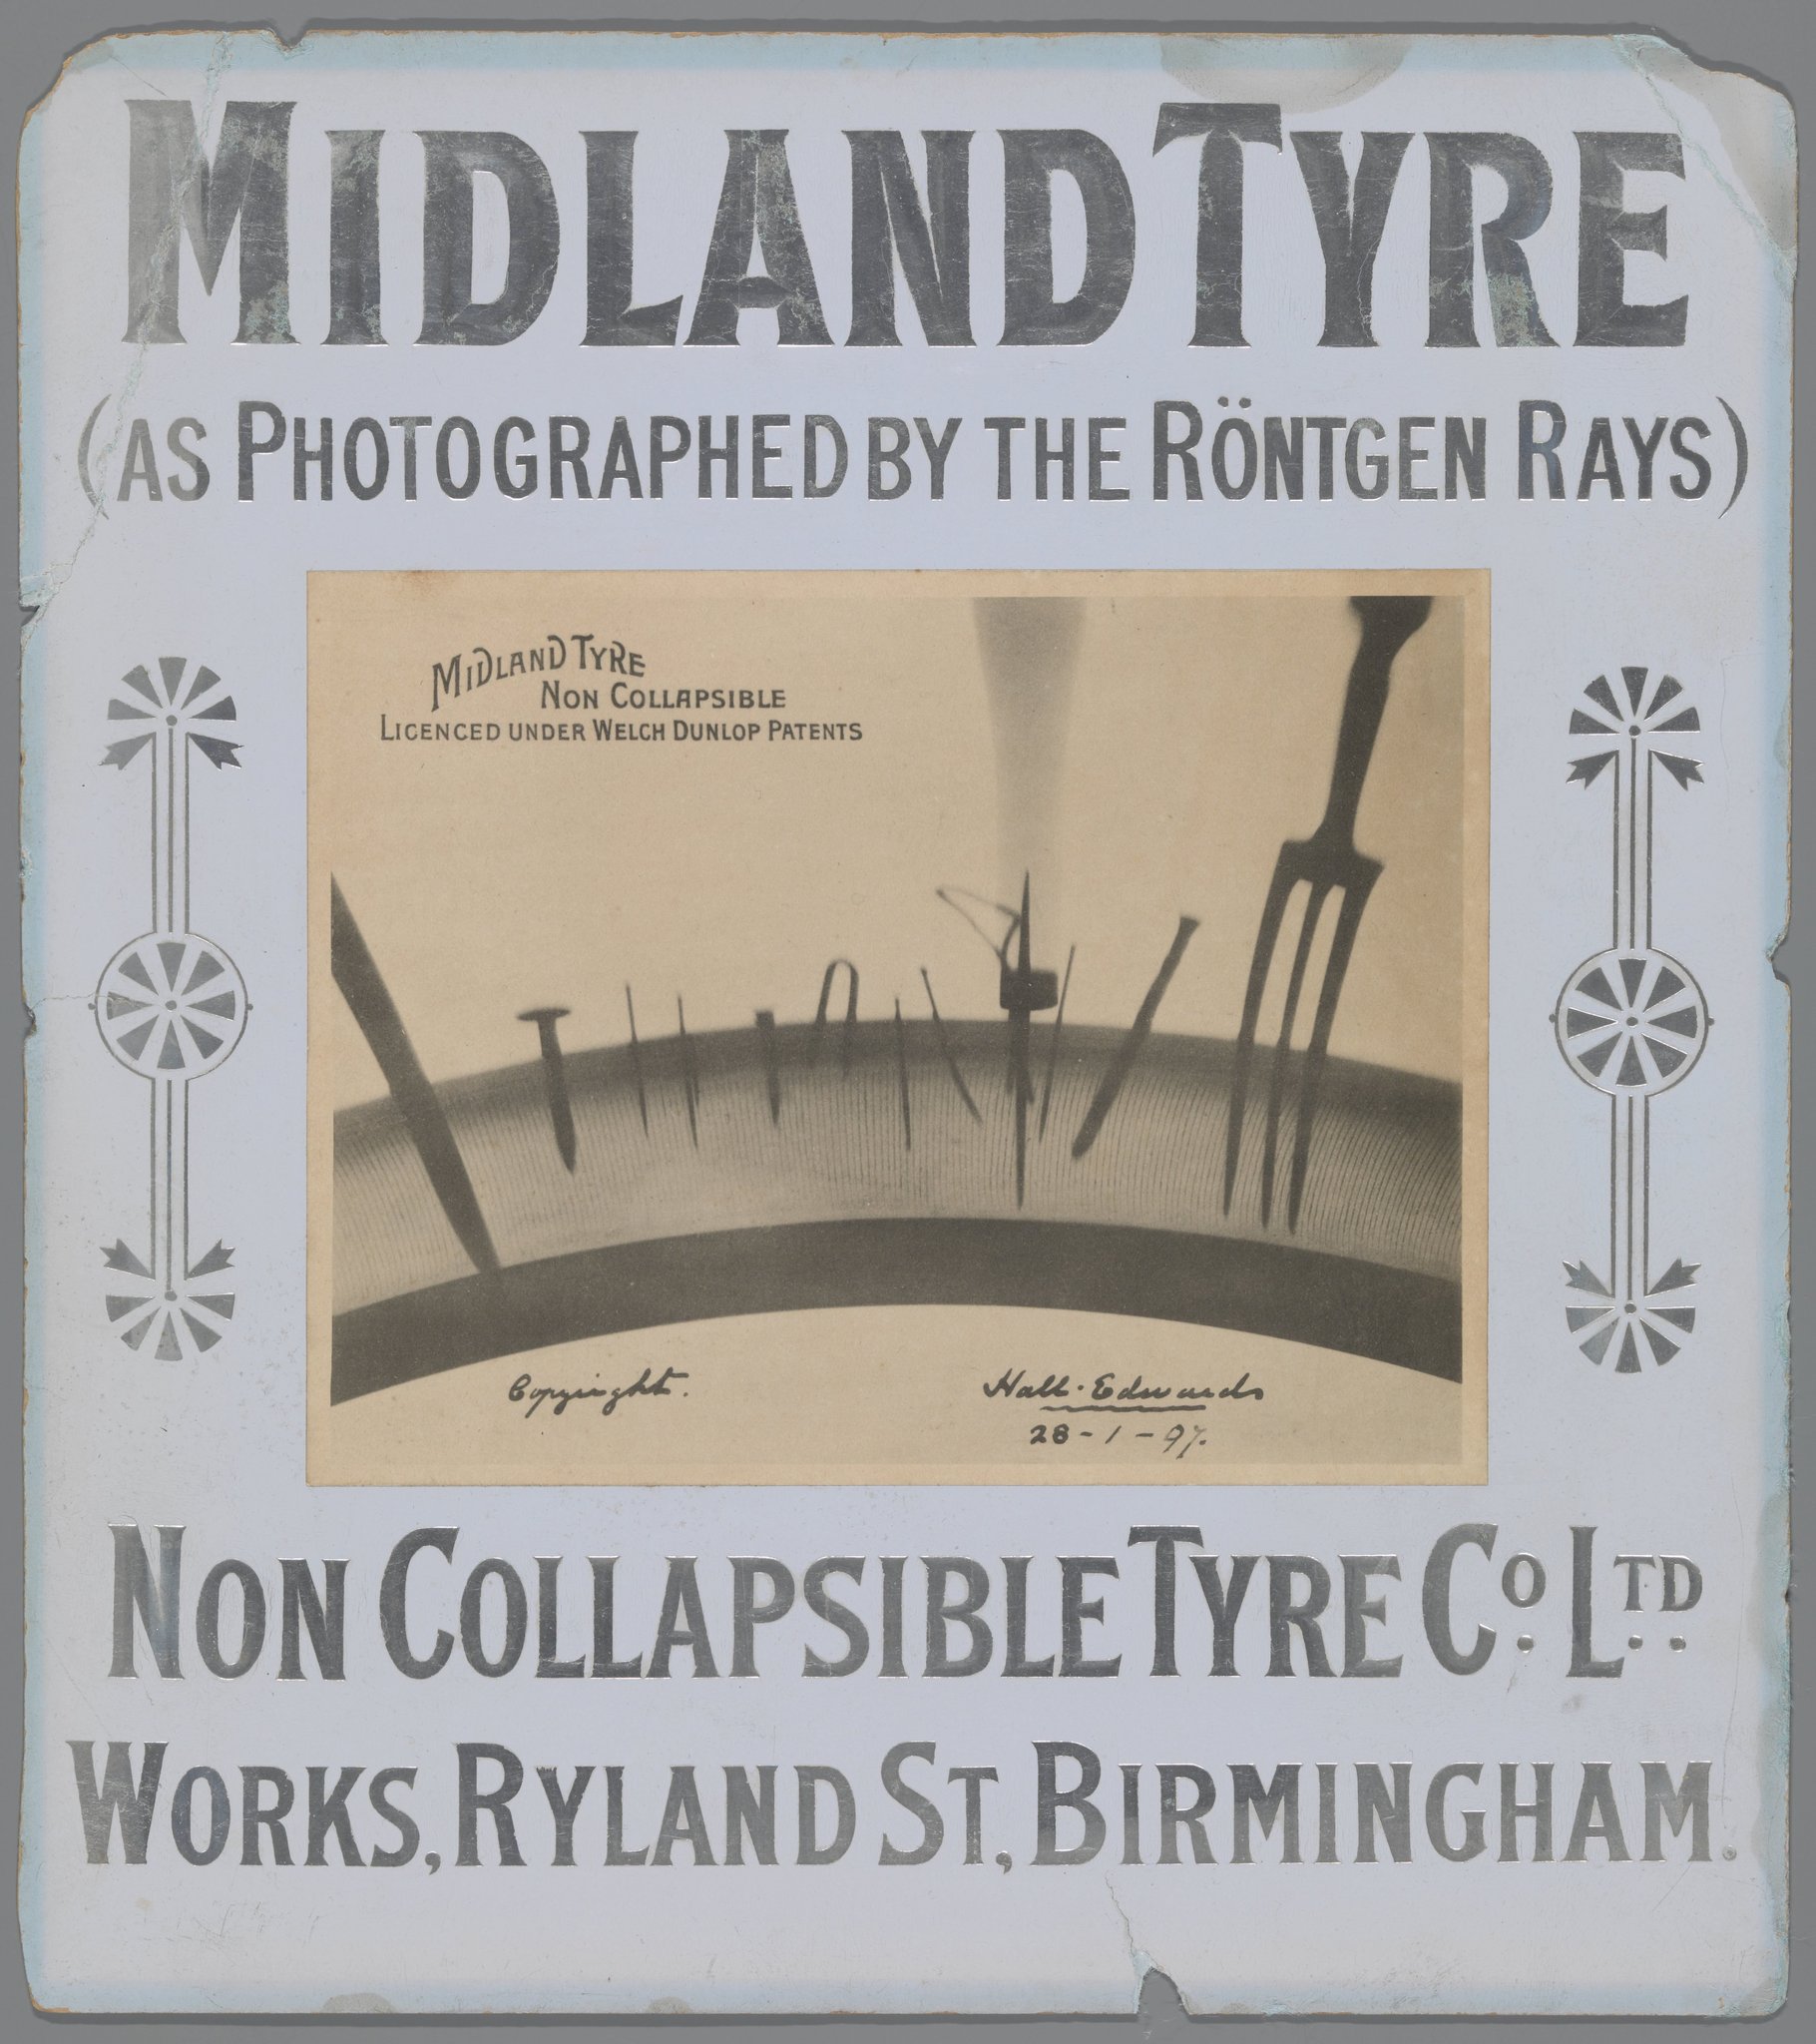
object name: x ray photograph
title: Advertisement for the non-collapsible Midland Tyre Company with an X-ray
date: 1897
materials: cardboard, paper, photographic support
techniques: photograph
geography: birmingham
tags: x-ray examination, birmingham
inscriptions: inscription: ‘Midland Tyre/ Non Collapsible/ Licenced under Welch Dunlop Patents’, address: ‘Non Collapsible Tyre Co. Ltd./ Works, Ryland St, Birmingham.’, copyright notice: ‘Copyright. Hall-Edwards/ 28-1-97.’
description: X-ray photography was also used for advertising purposes, of which this photograph is a very early example. The cardboard billboard with the photograph pasted on it was intended for bicycle dealers. It was produced in (small) numbers and distributed to workshops and stores throughout England. At that time, cycling was becoming all the rage. The advertisement illustrates just how strong the rubber tyre is when punctured by all manner of sharp objects?